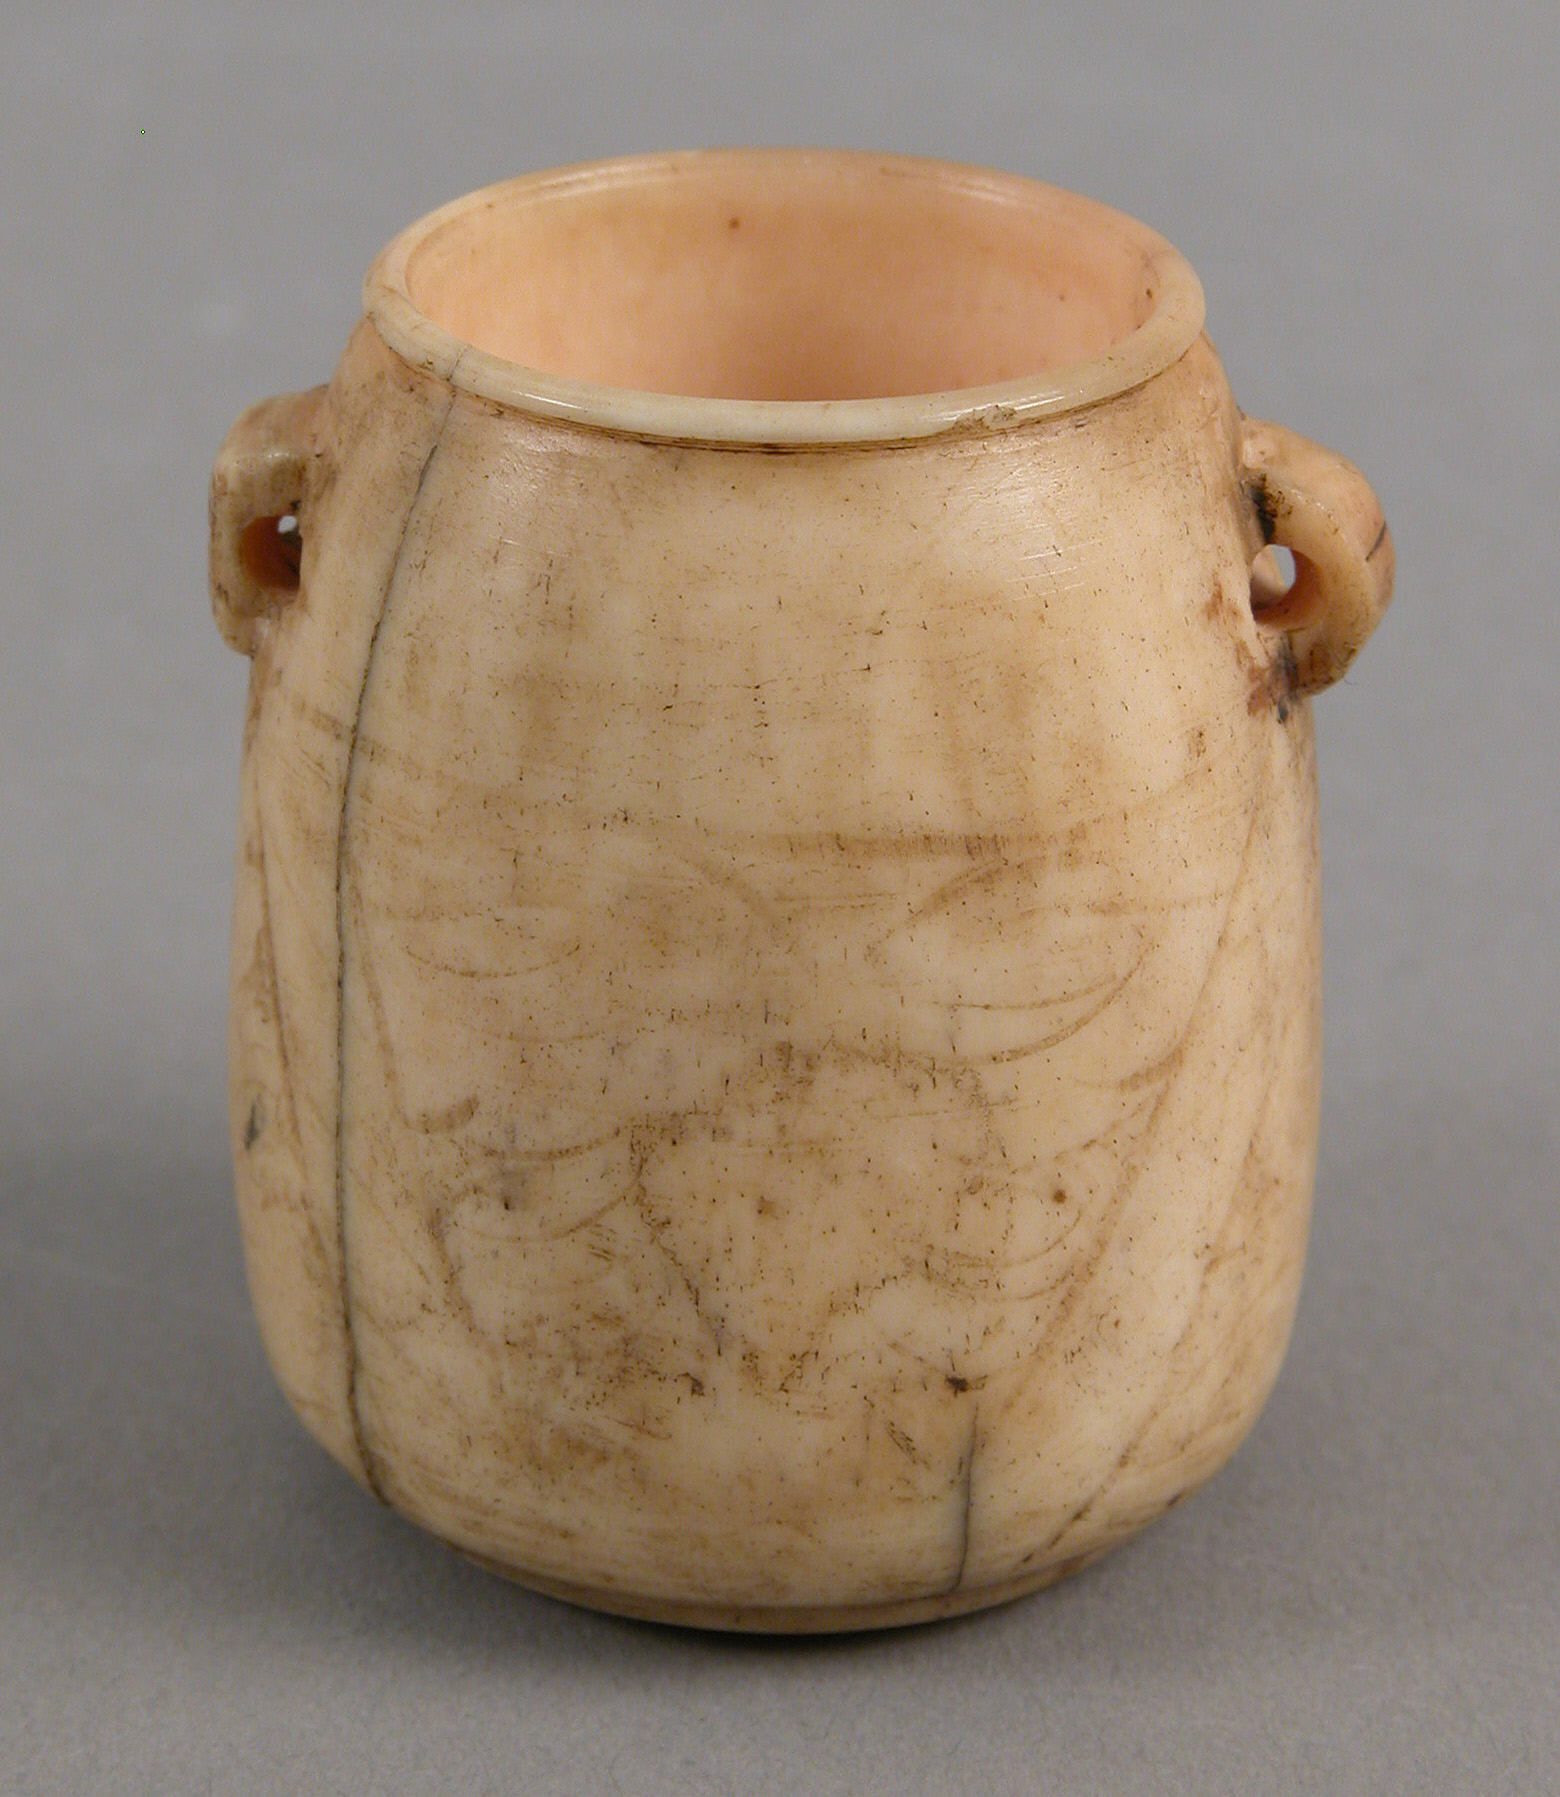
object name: toilet vase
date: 501-600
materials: bone, ivory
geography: egypt